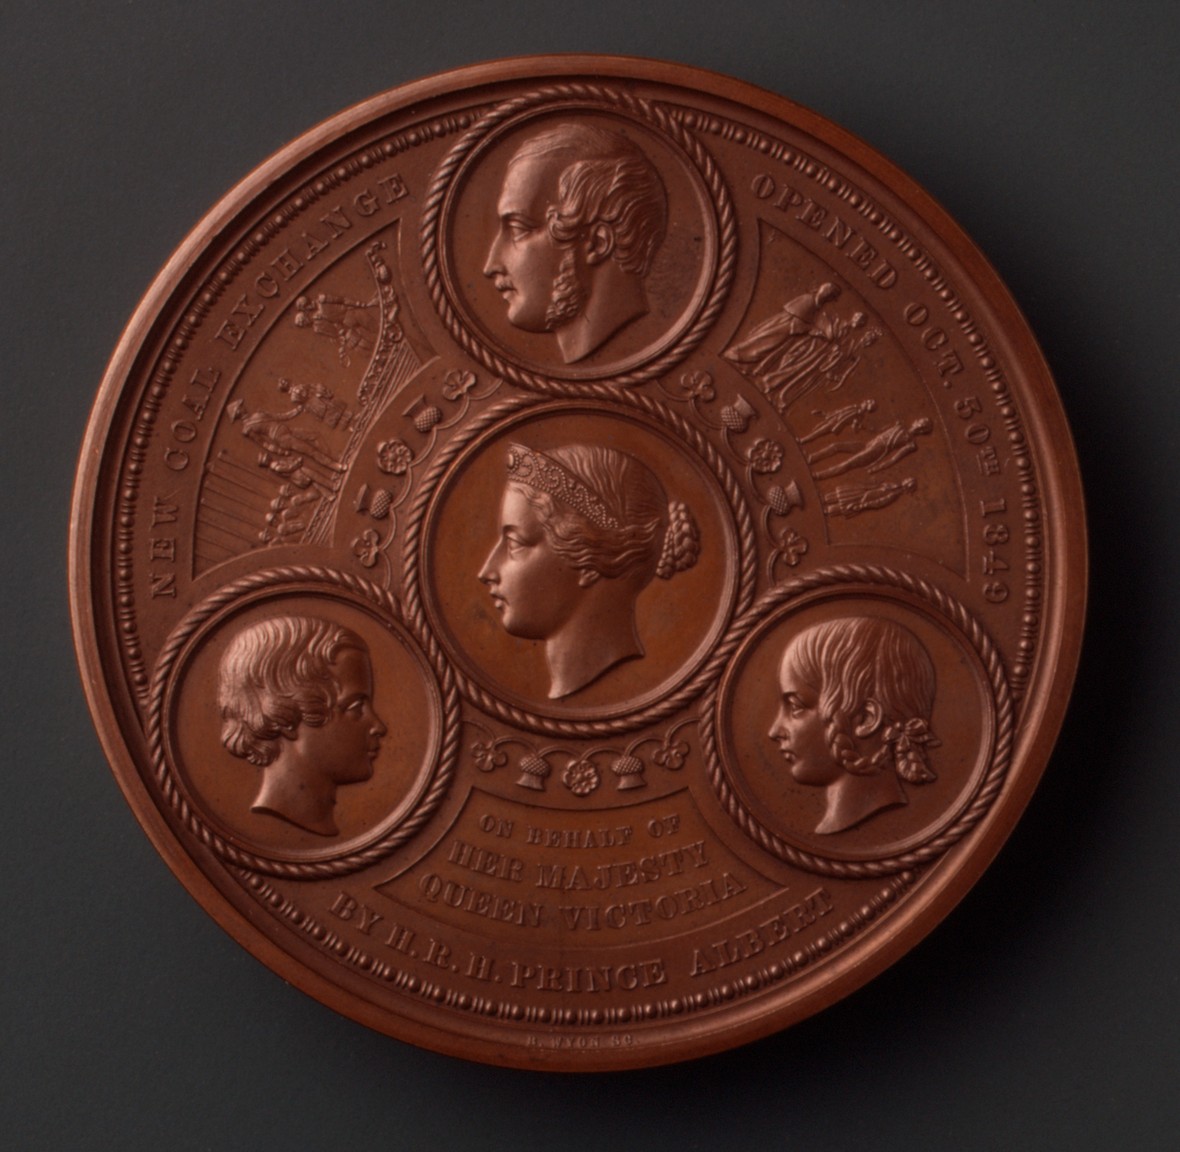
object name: medal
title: The Opening of the New Coal Exchange, on Behalf of the Queen, by Prince Albert, Accompanied by two of the Royal Children, the Prince of Wales and the Princess Royal, October 30, 1849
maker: benjamin wyon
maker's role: artist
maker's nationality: british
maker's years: 1802-1858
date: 1849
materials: bronze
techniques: struck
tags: princes,princesses,queens,profiles